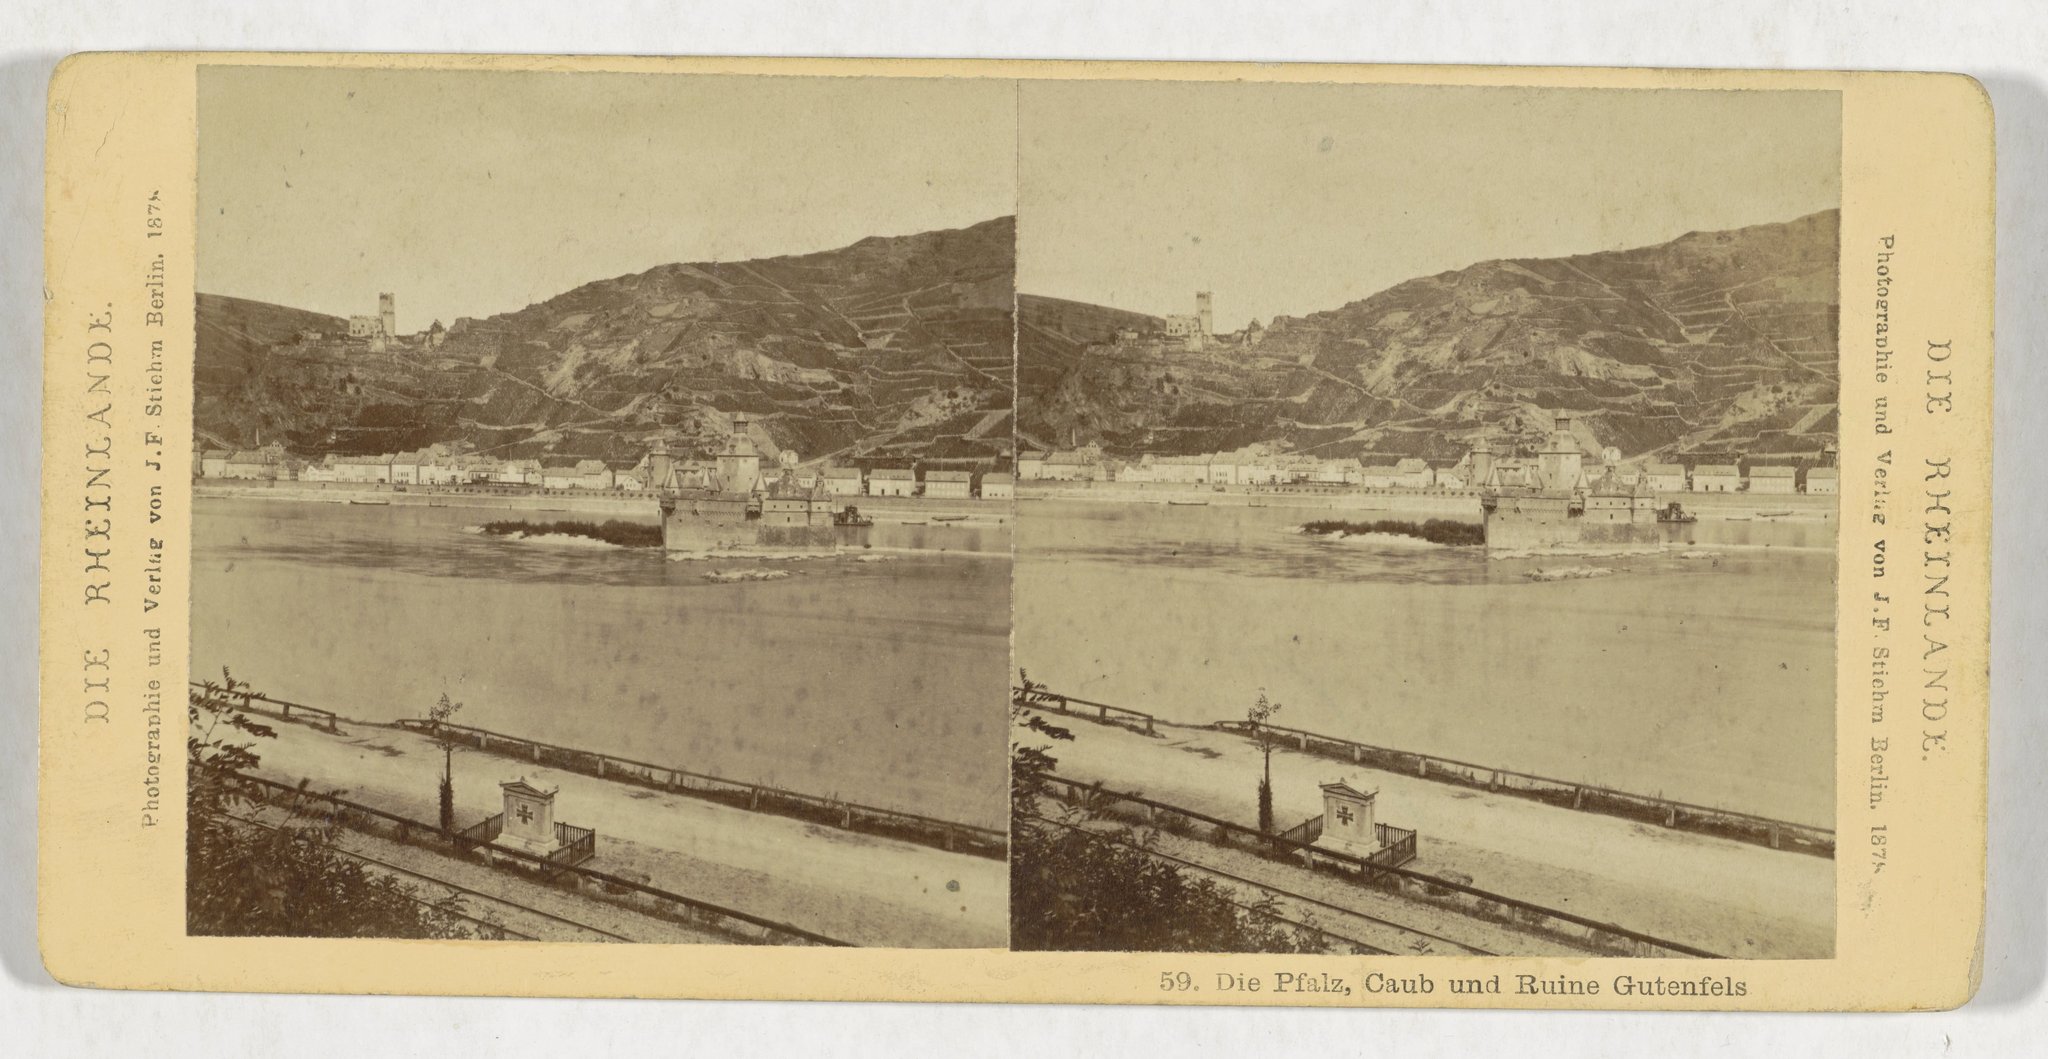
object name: stereograph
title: Die Rheinlande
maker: johann friedrich stiehm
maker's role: fotograaf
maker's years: 1826-1902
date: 1878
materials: cardboard, paper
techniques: albumen print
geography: kaub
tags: city-view in general; 'veduta', castle, river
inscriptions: inscription: ‘04’, number: ‘59.’